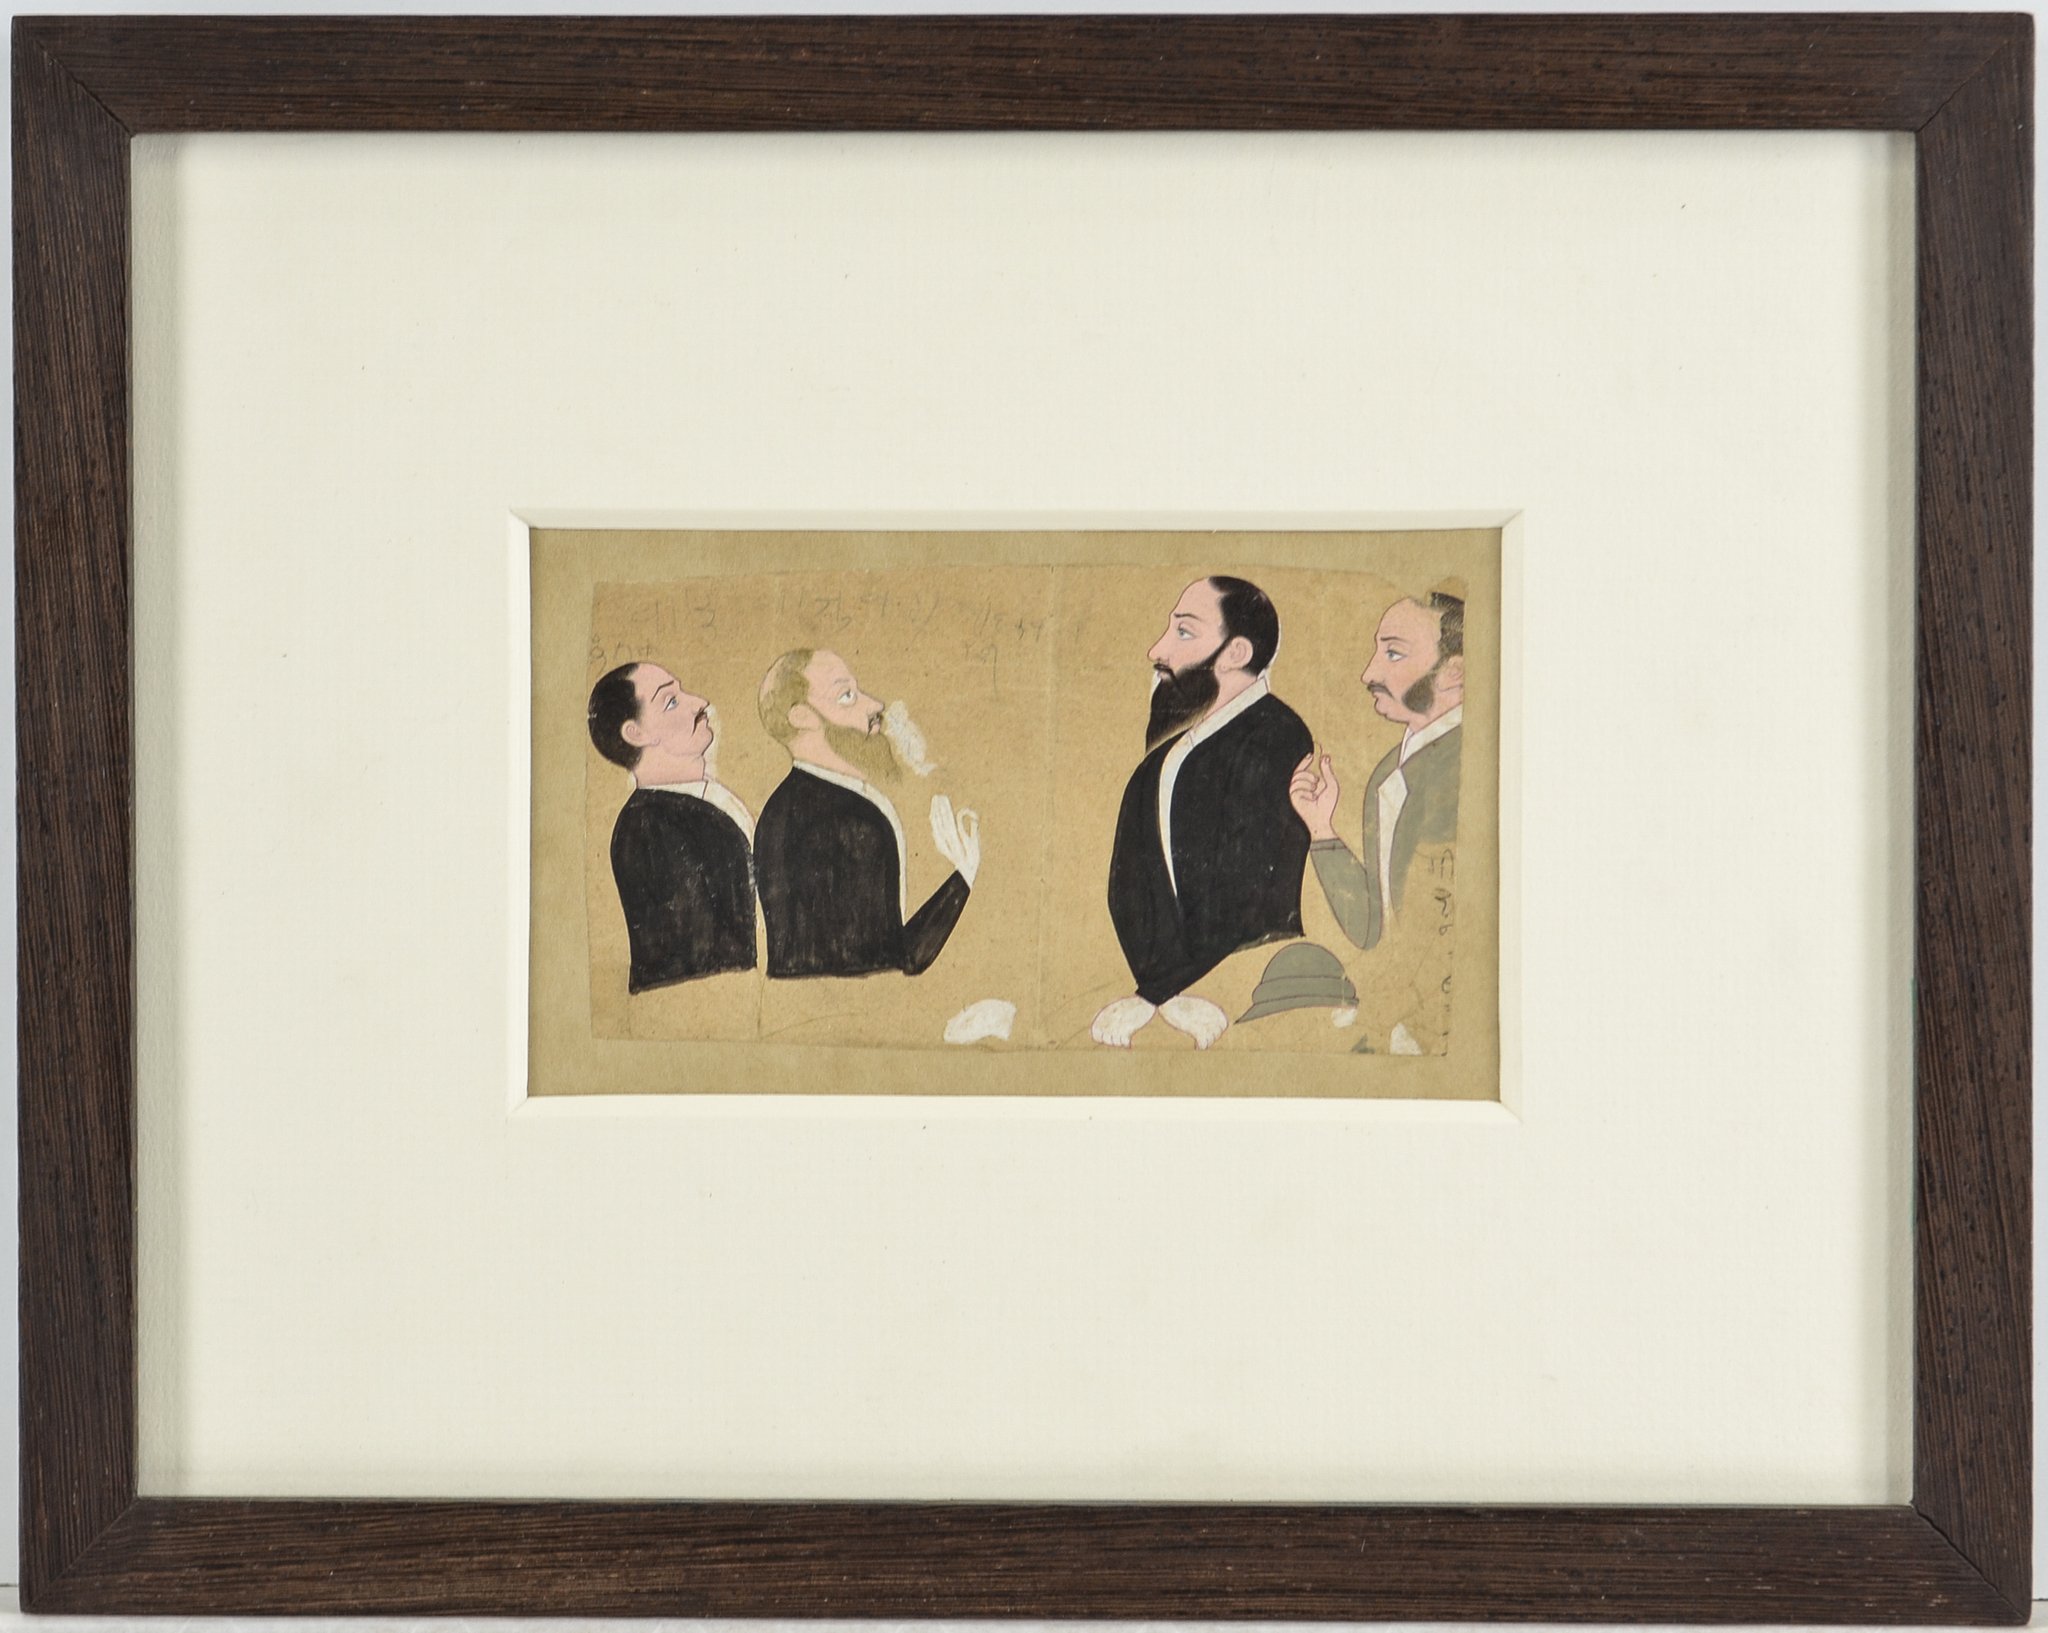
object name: illustrated single work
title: Four European Gentlemen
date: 1860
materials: paper, pigment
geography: india